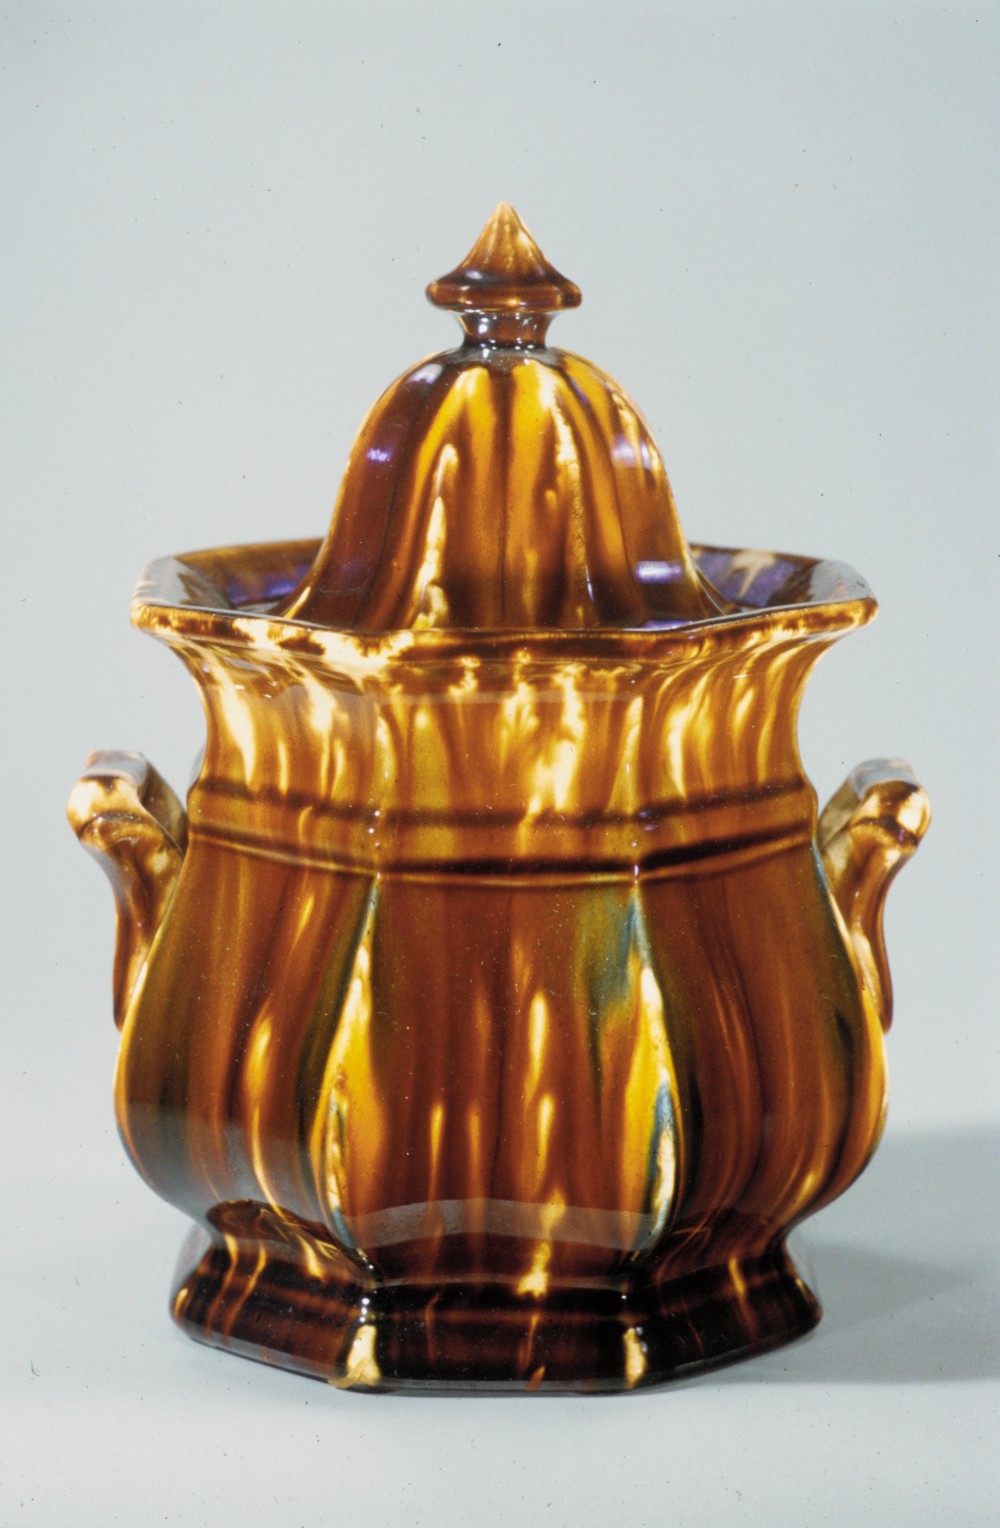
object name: sugar bowl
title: Covered Sugar Bowl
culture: american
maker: united states pottery company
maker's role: maker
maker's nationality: american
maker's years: 1852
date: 1849-1858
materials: earthenware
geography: united states